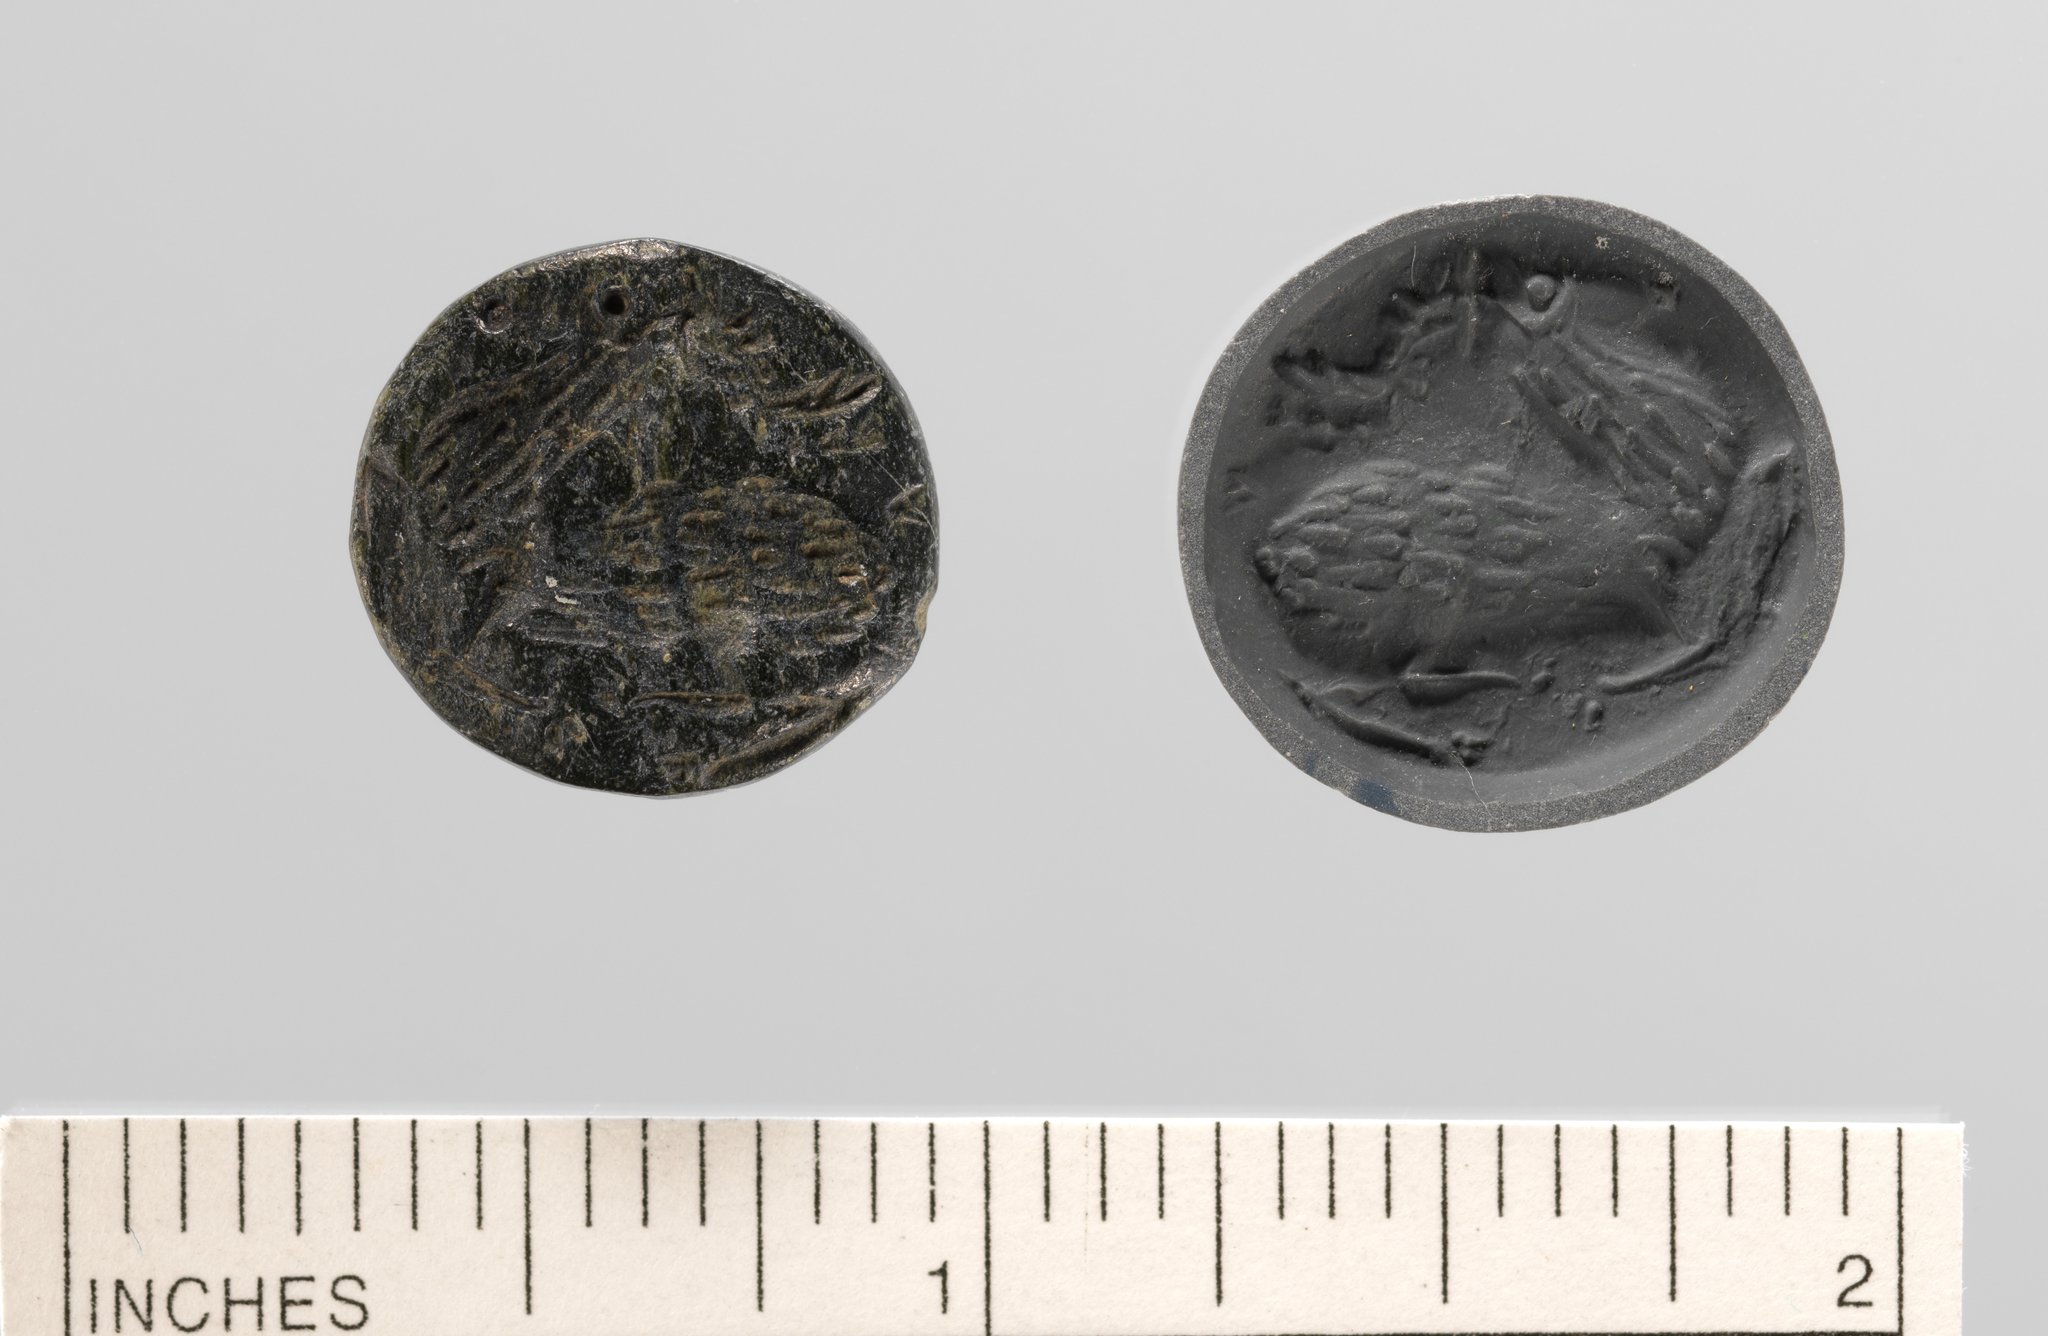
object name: seal, lentoid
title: Serpentine Lentoid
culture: minoan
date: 1450-1375 BCE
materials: stone